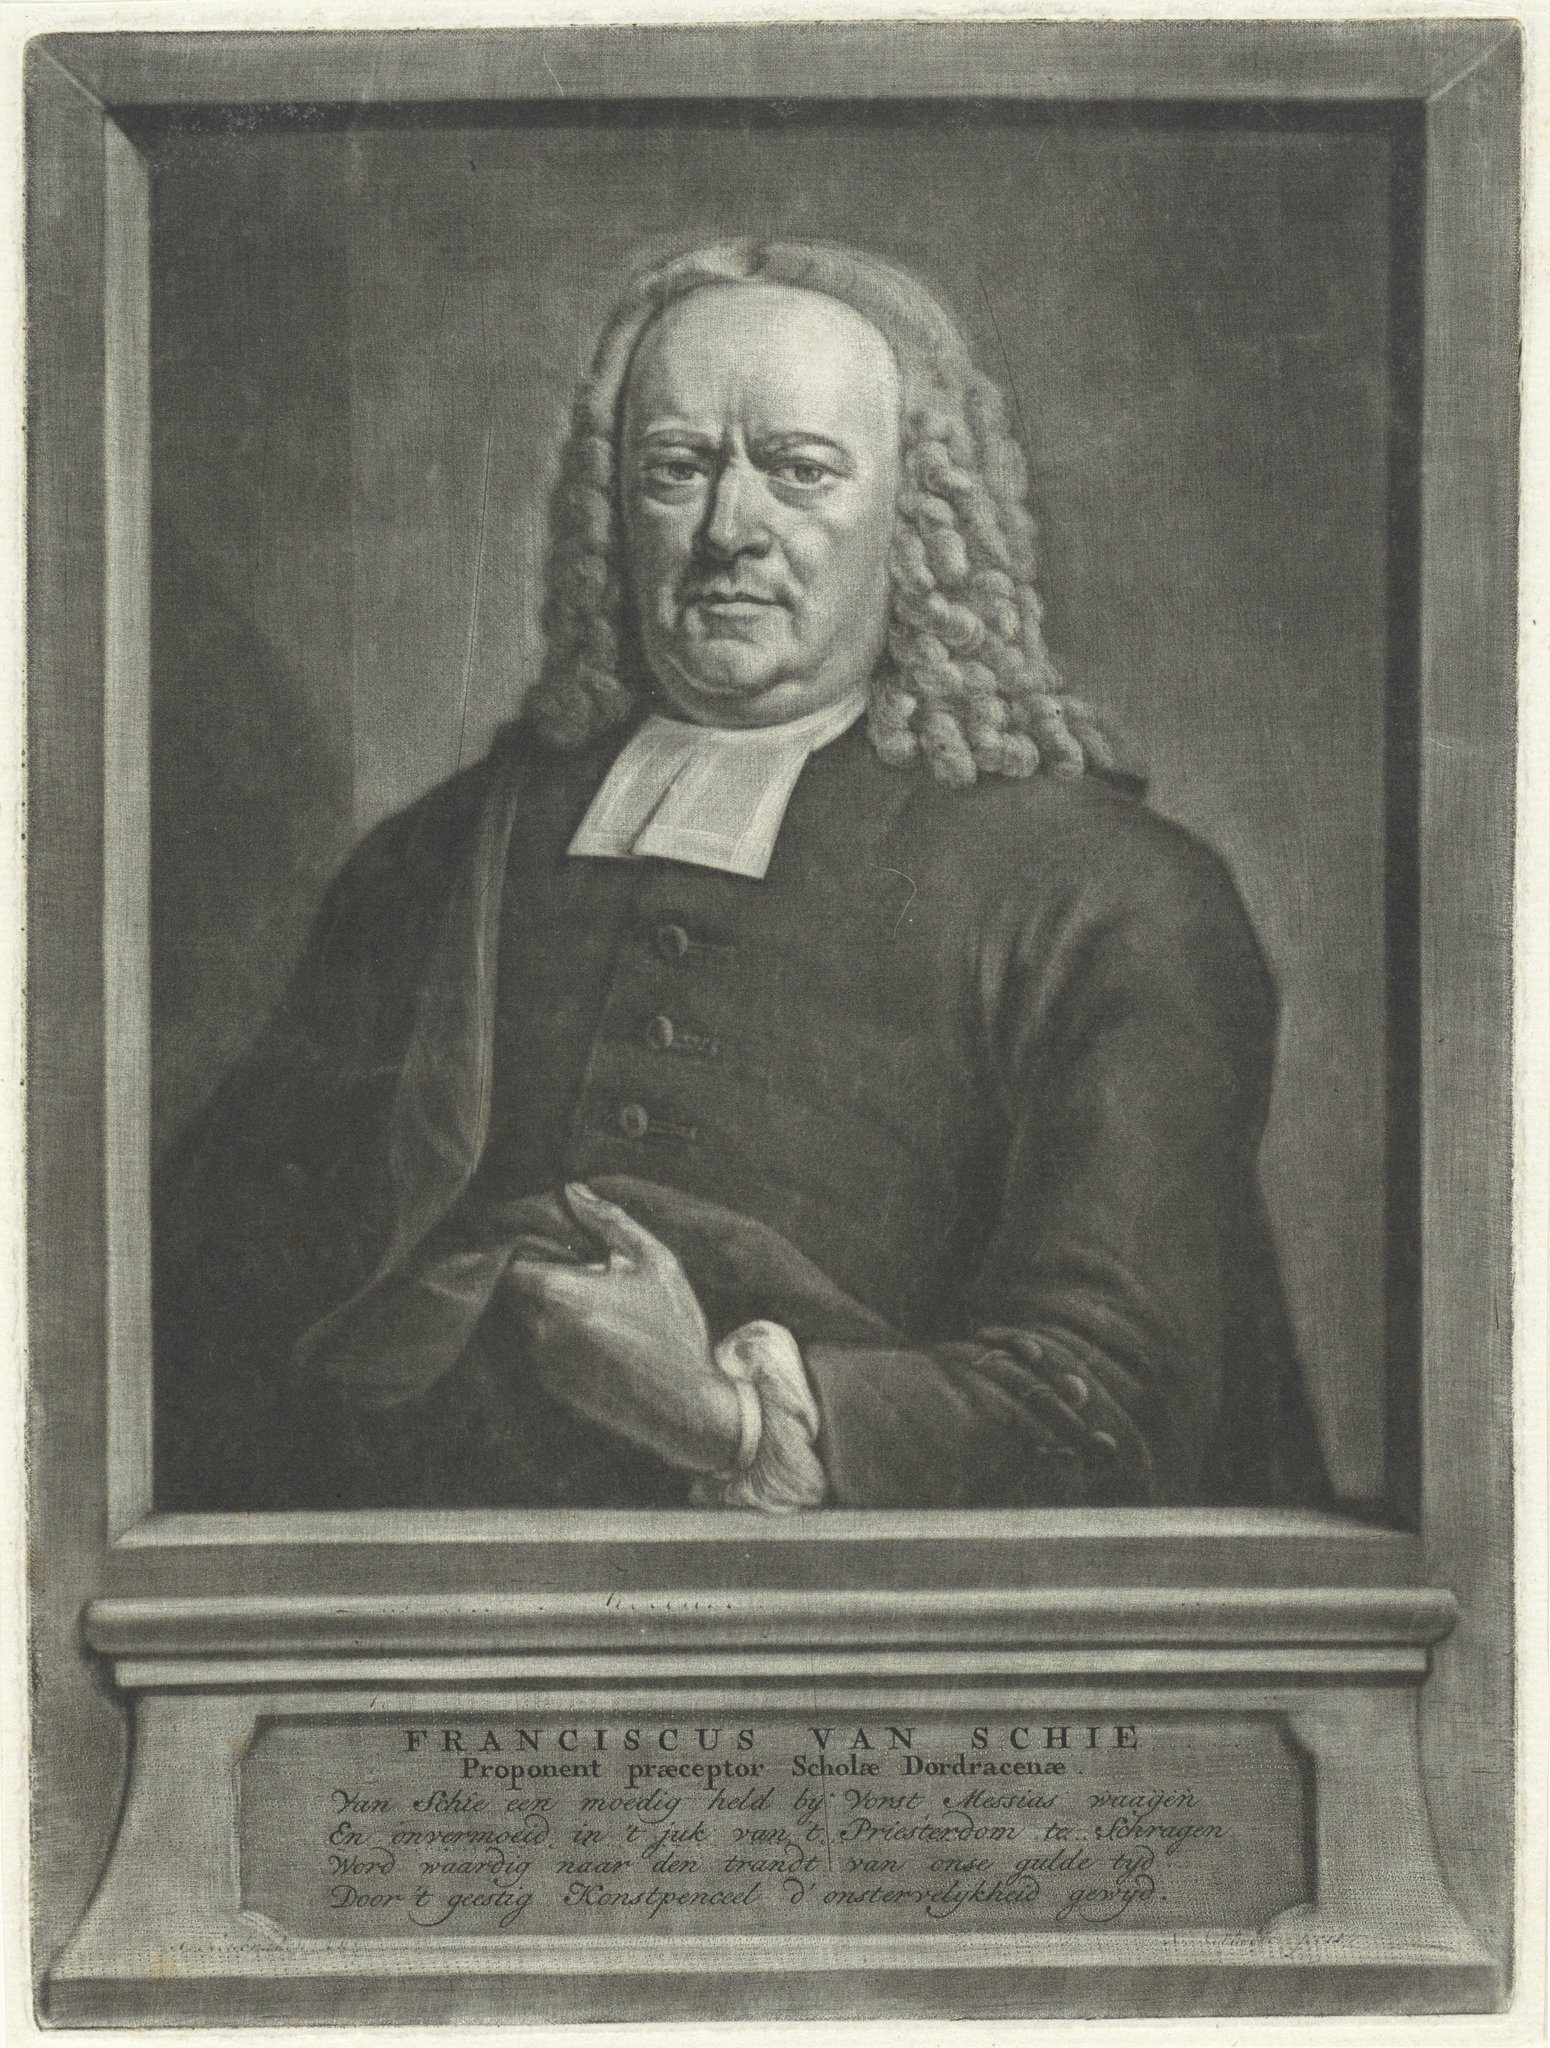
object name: print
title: Portret van de predikant Franciscus van Schie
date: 1683-1746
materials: paper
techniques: engraving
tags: wig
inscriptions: collector's mark: Lugt 2228